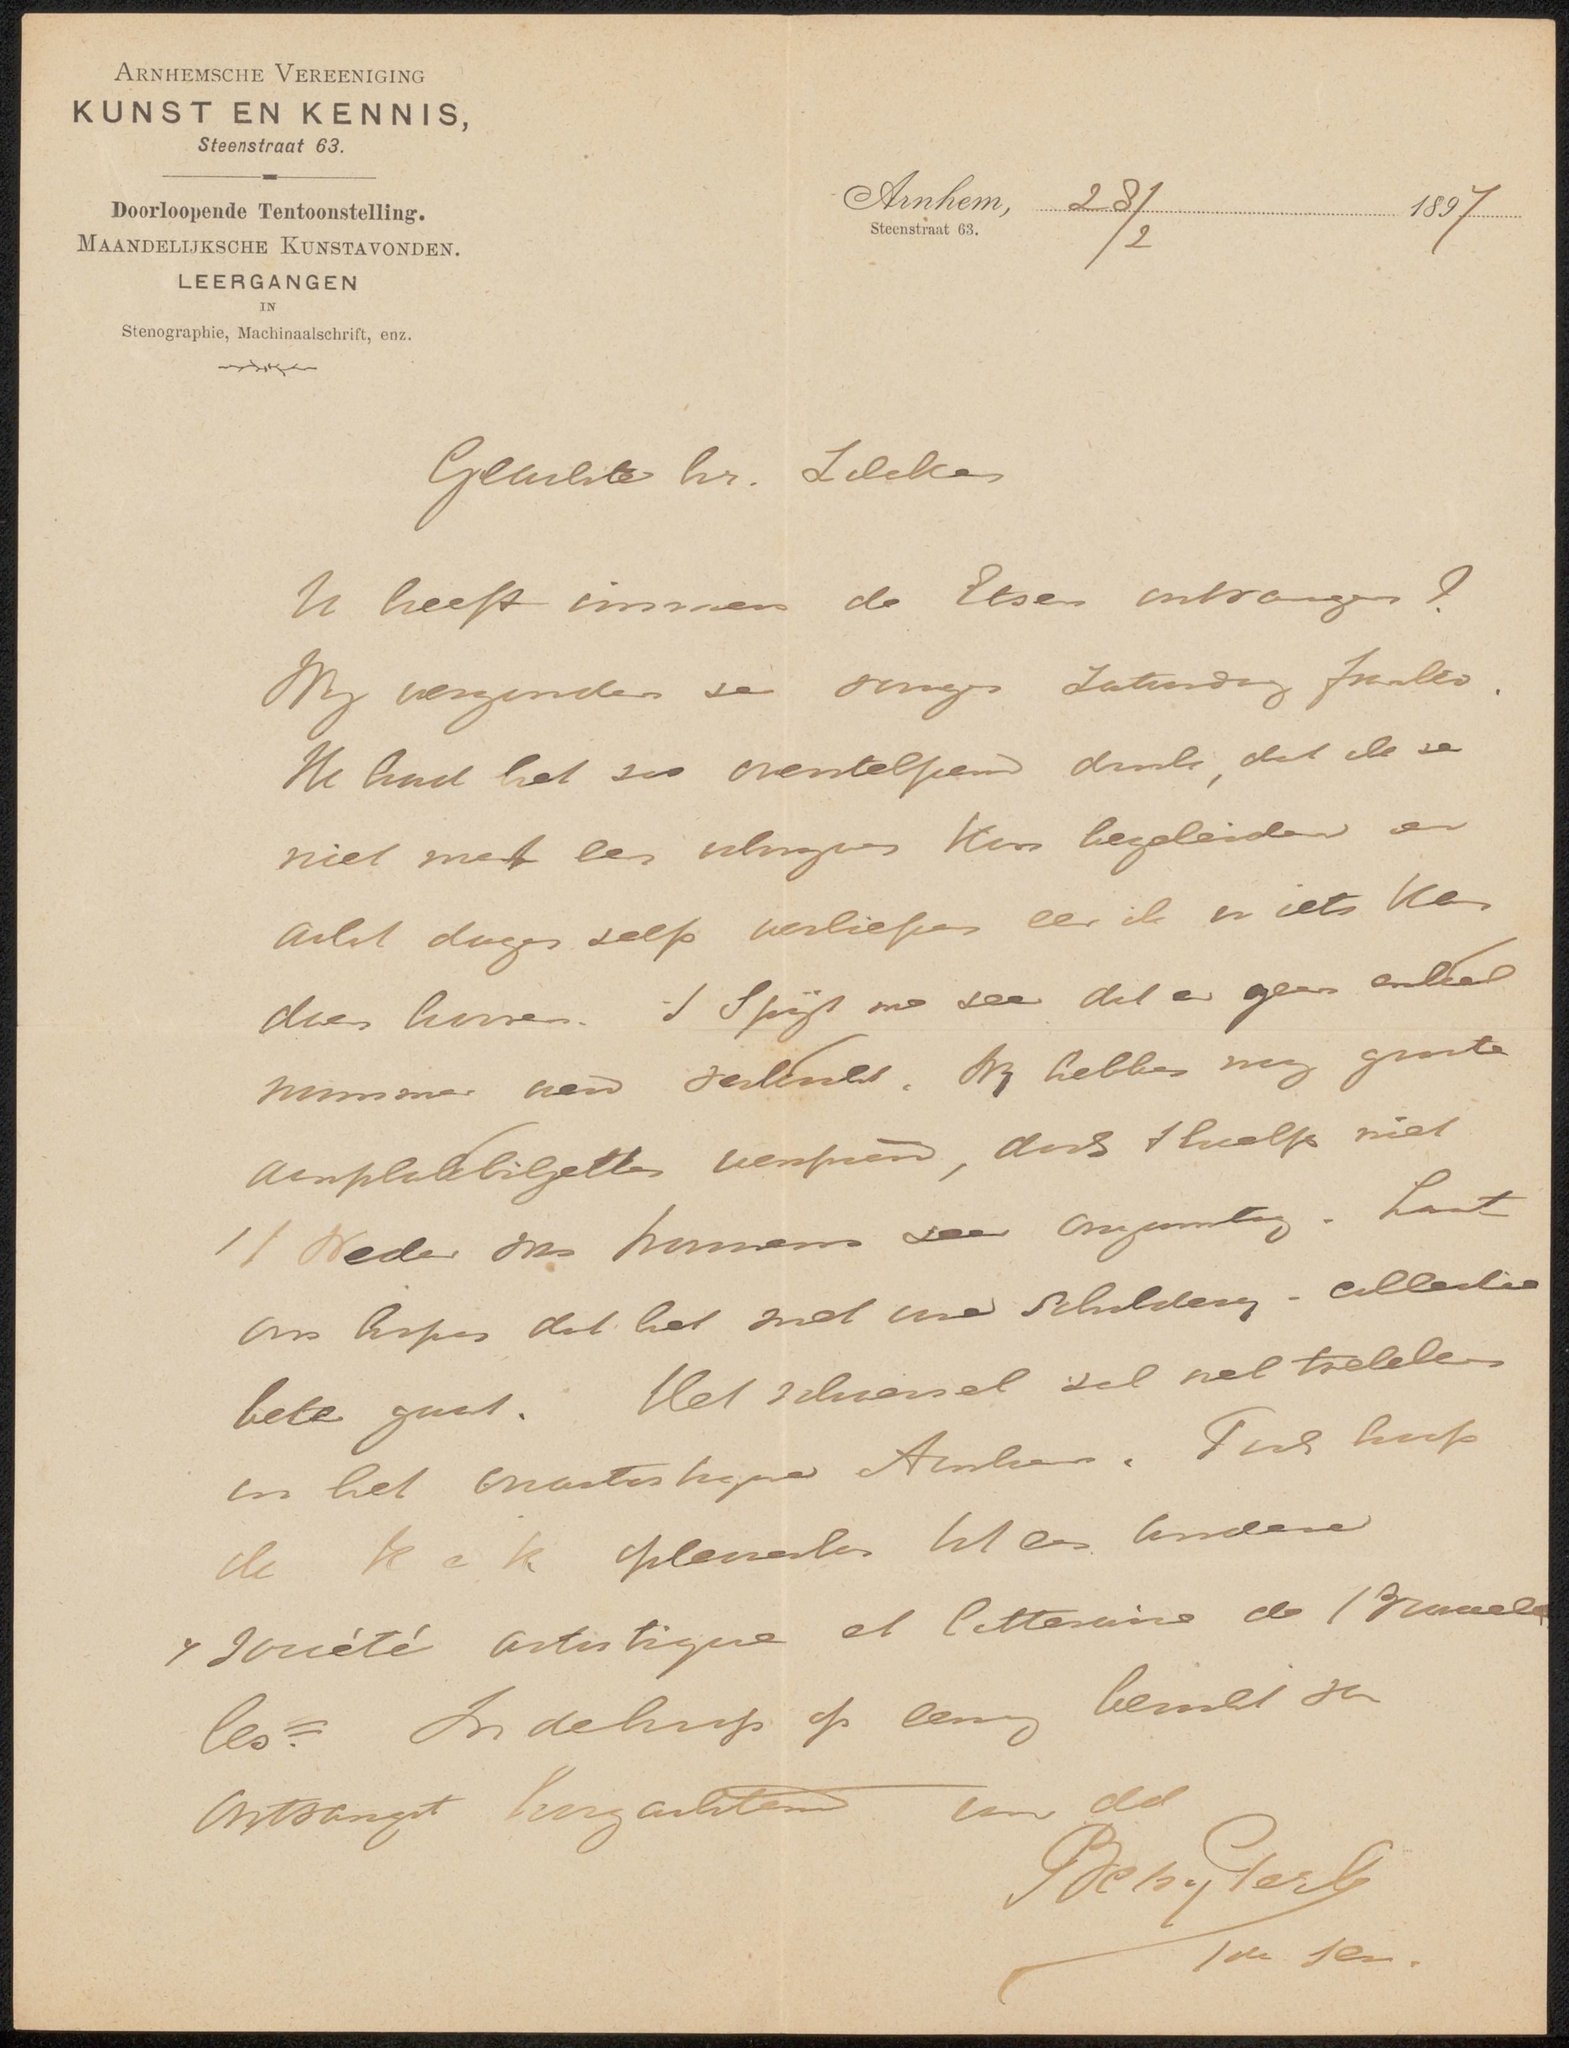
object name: letter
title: Brief aan Philip Zilcken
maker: christina elizabeth perk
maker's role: painter, sculptor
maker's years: 1833-1906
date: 1897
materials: ink, paper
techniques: pen, printing, writing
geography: arnhem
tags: the hague, painter, draughtsman, philip zilcken, applied arts, arts and crafts; industrial design, the graphic arts, painting (including book-illumination, miniature-painting), printed matter, arnhem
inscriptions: collector's mark: ‘RPK’